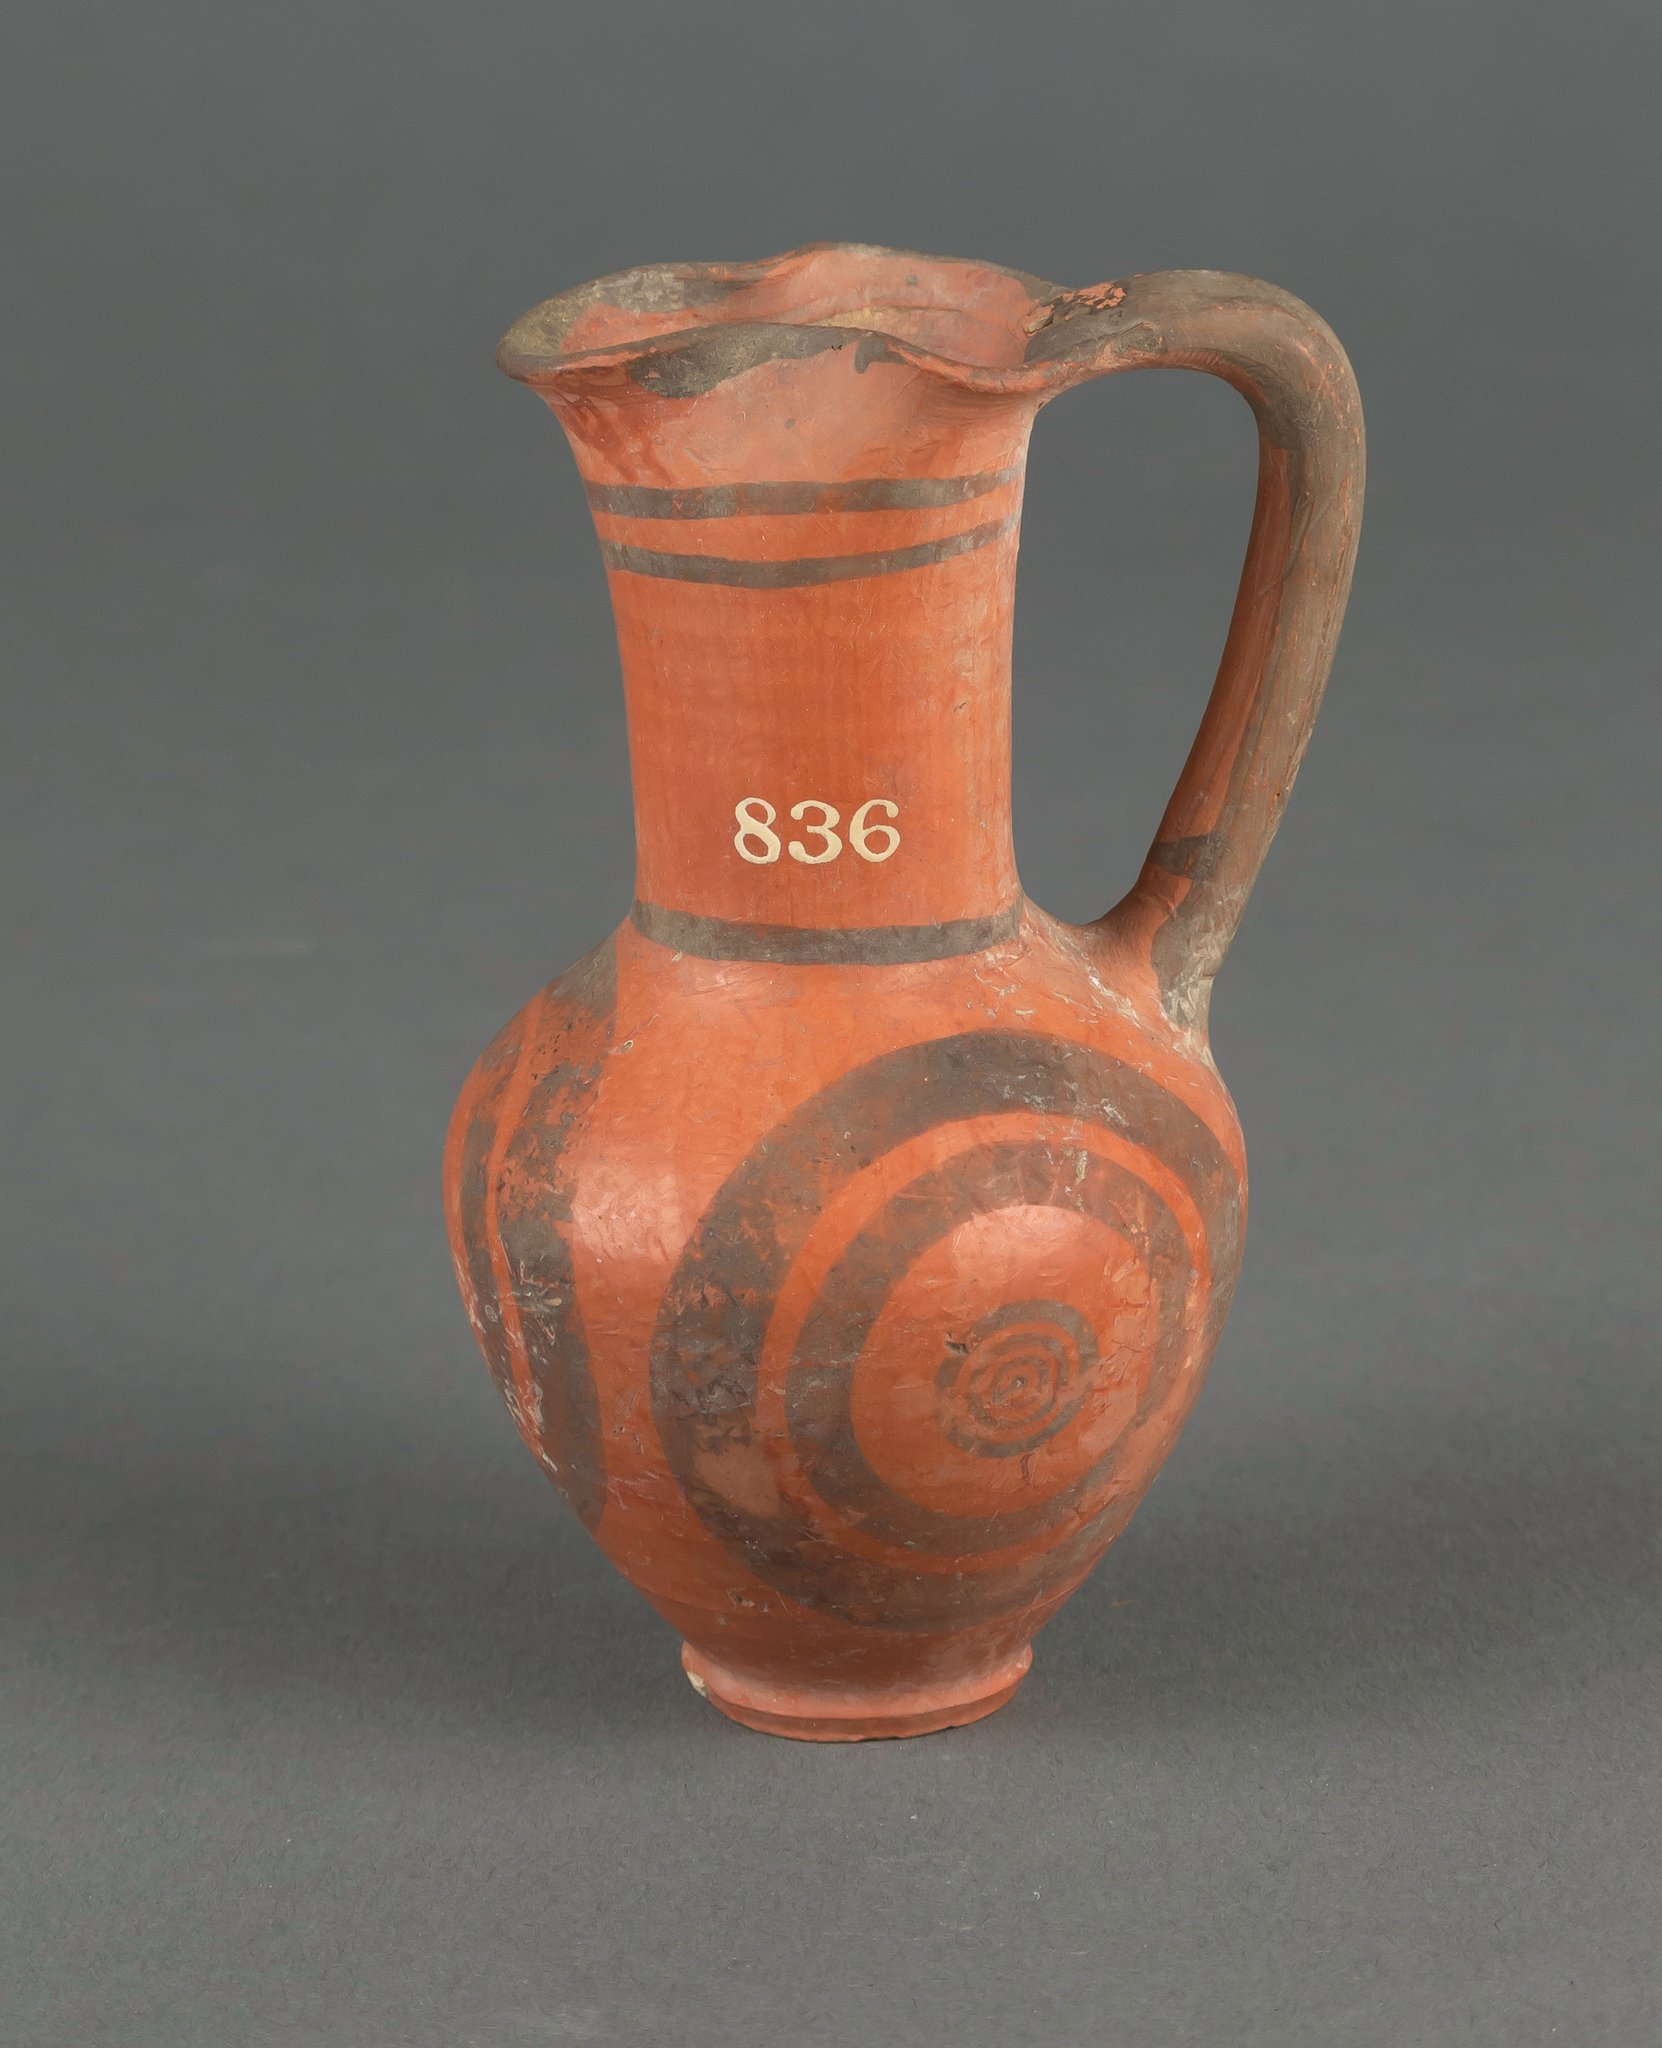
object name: juglet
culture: cypriot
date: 750-600 BCE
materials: terracotta